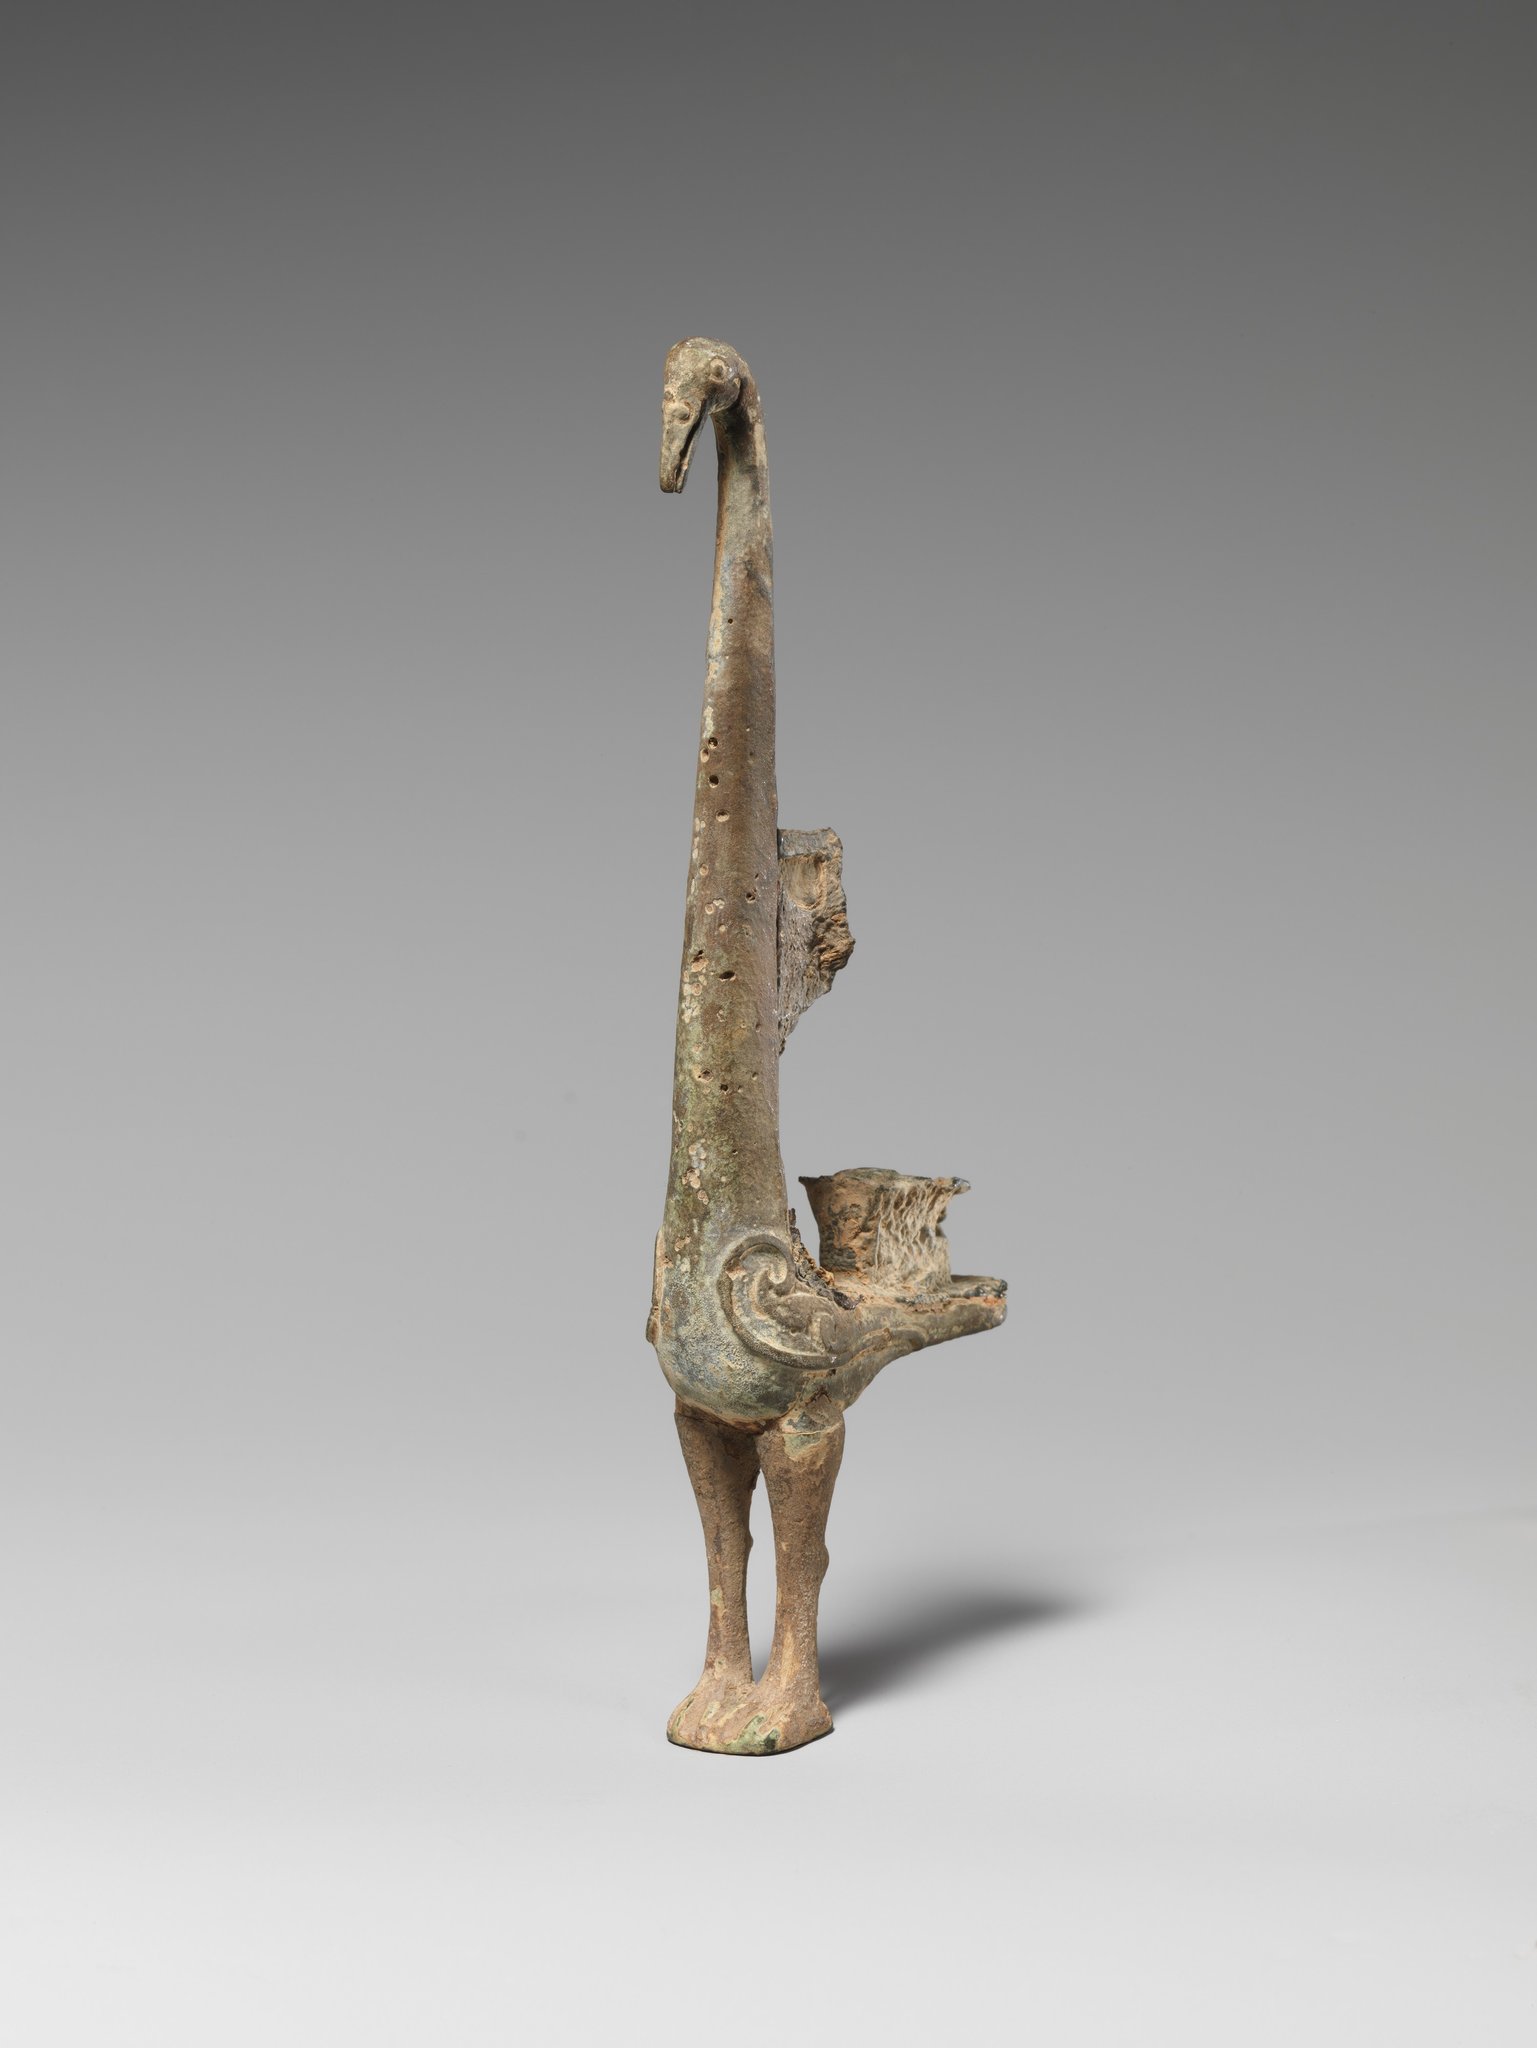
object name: vessel leg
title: Vessel leg in the form of a bird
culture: chinese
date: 500-201 BCE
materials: bronze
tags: birds